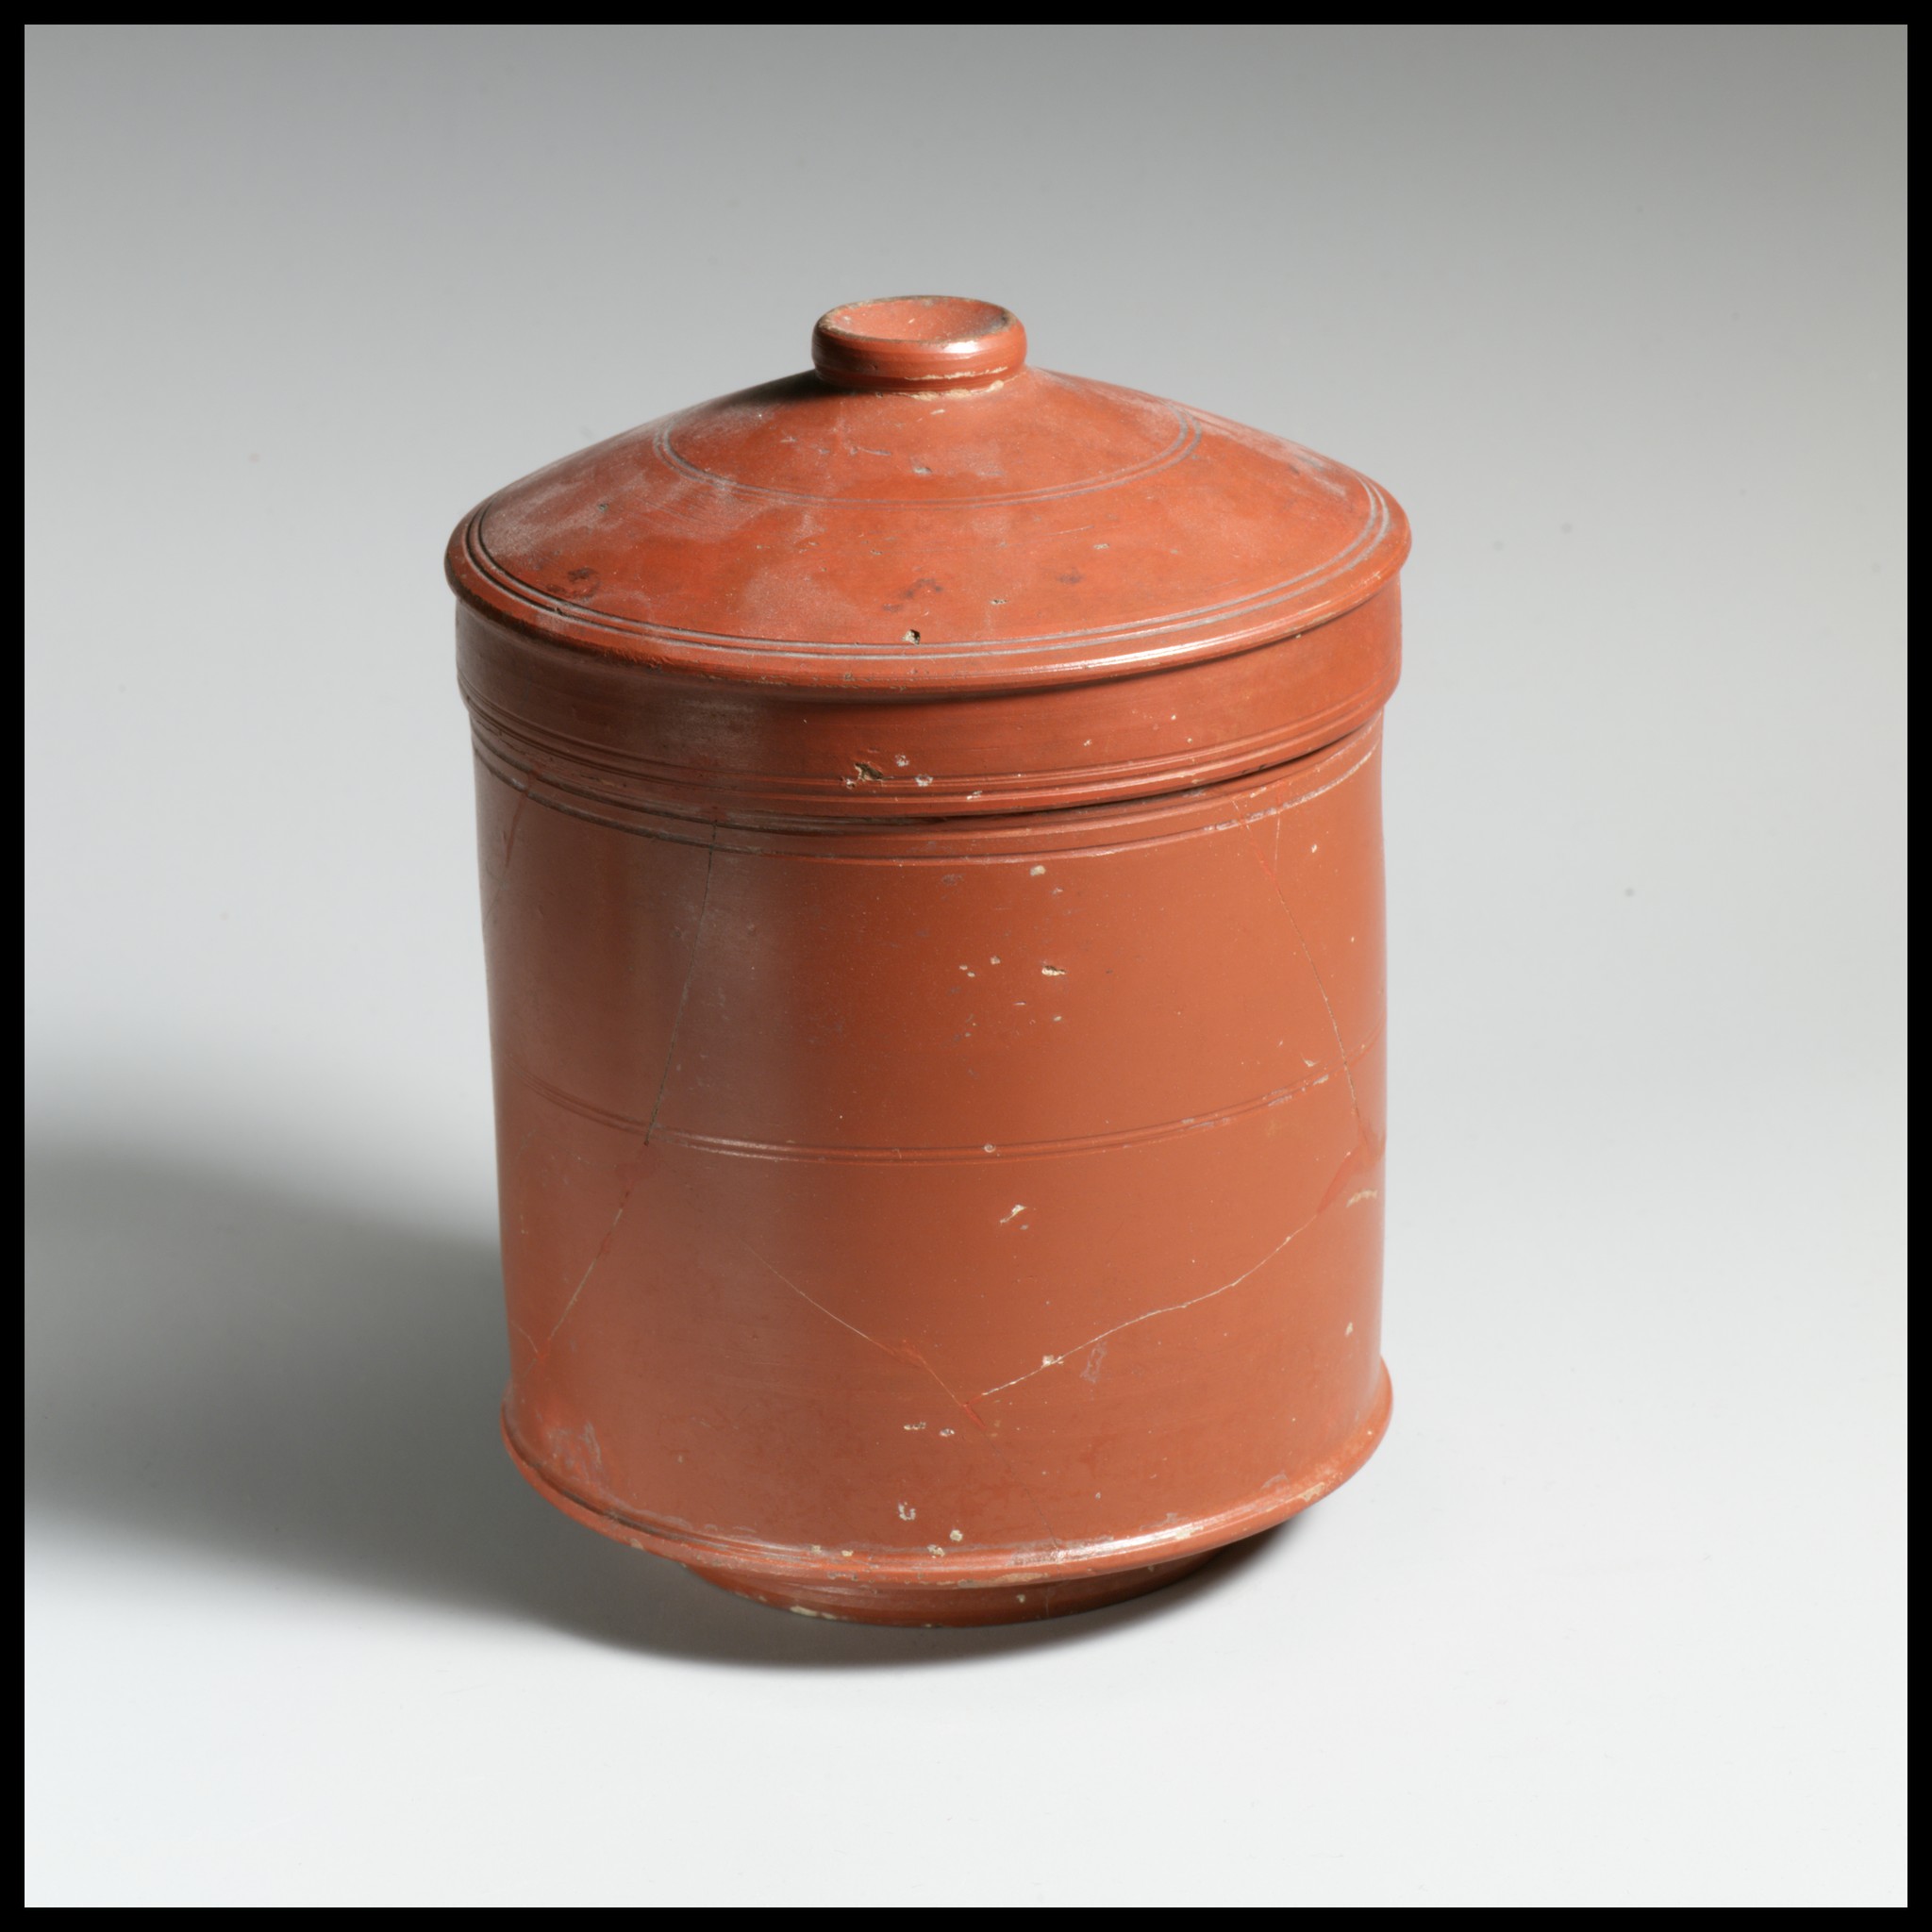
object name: pyxis with lid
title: Terracotta pyxis (box) with lid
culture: roman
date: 1-300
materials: terracotta